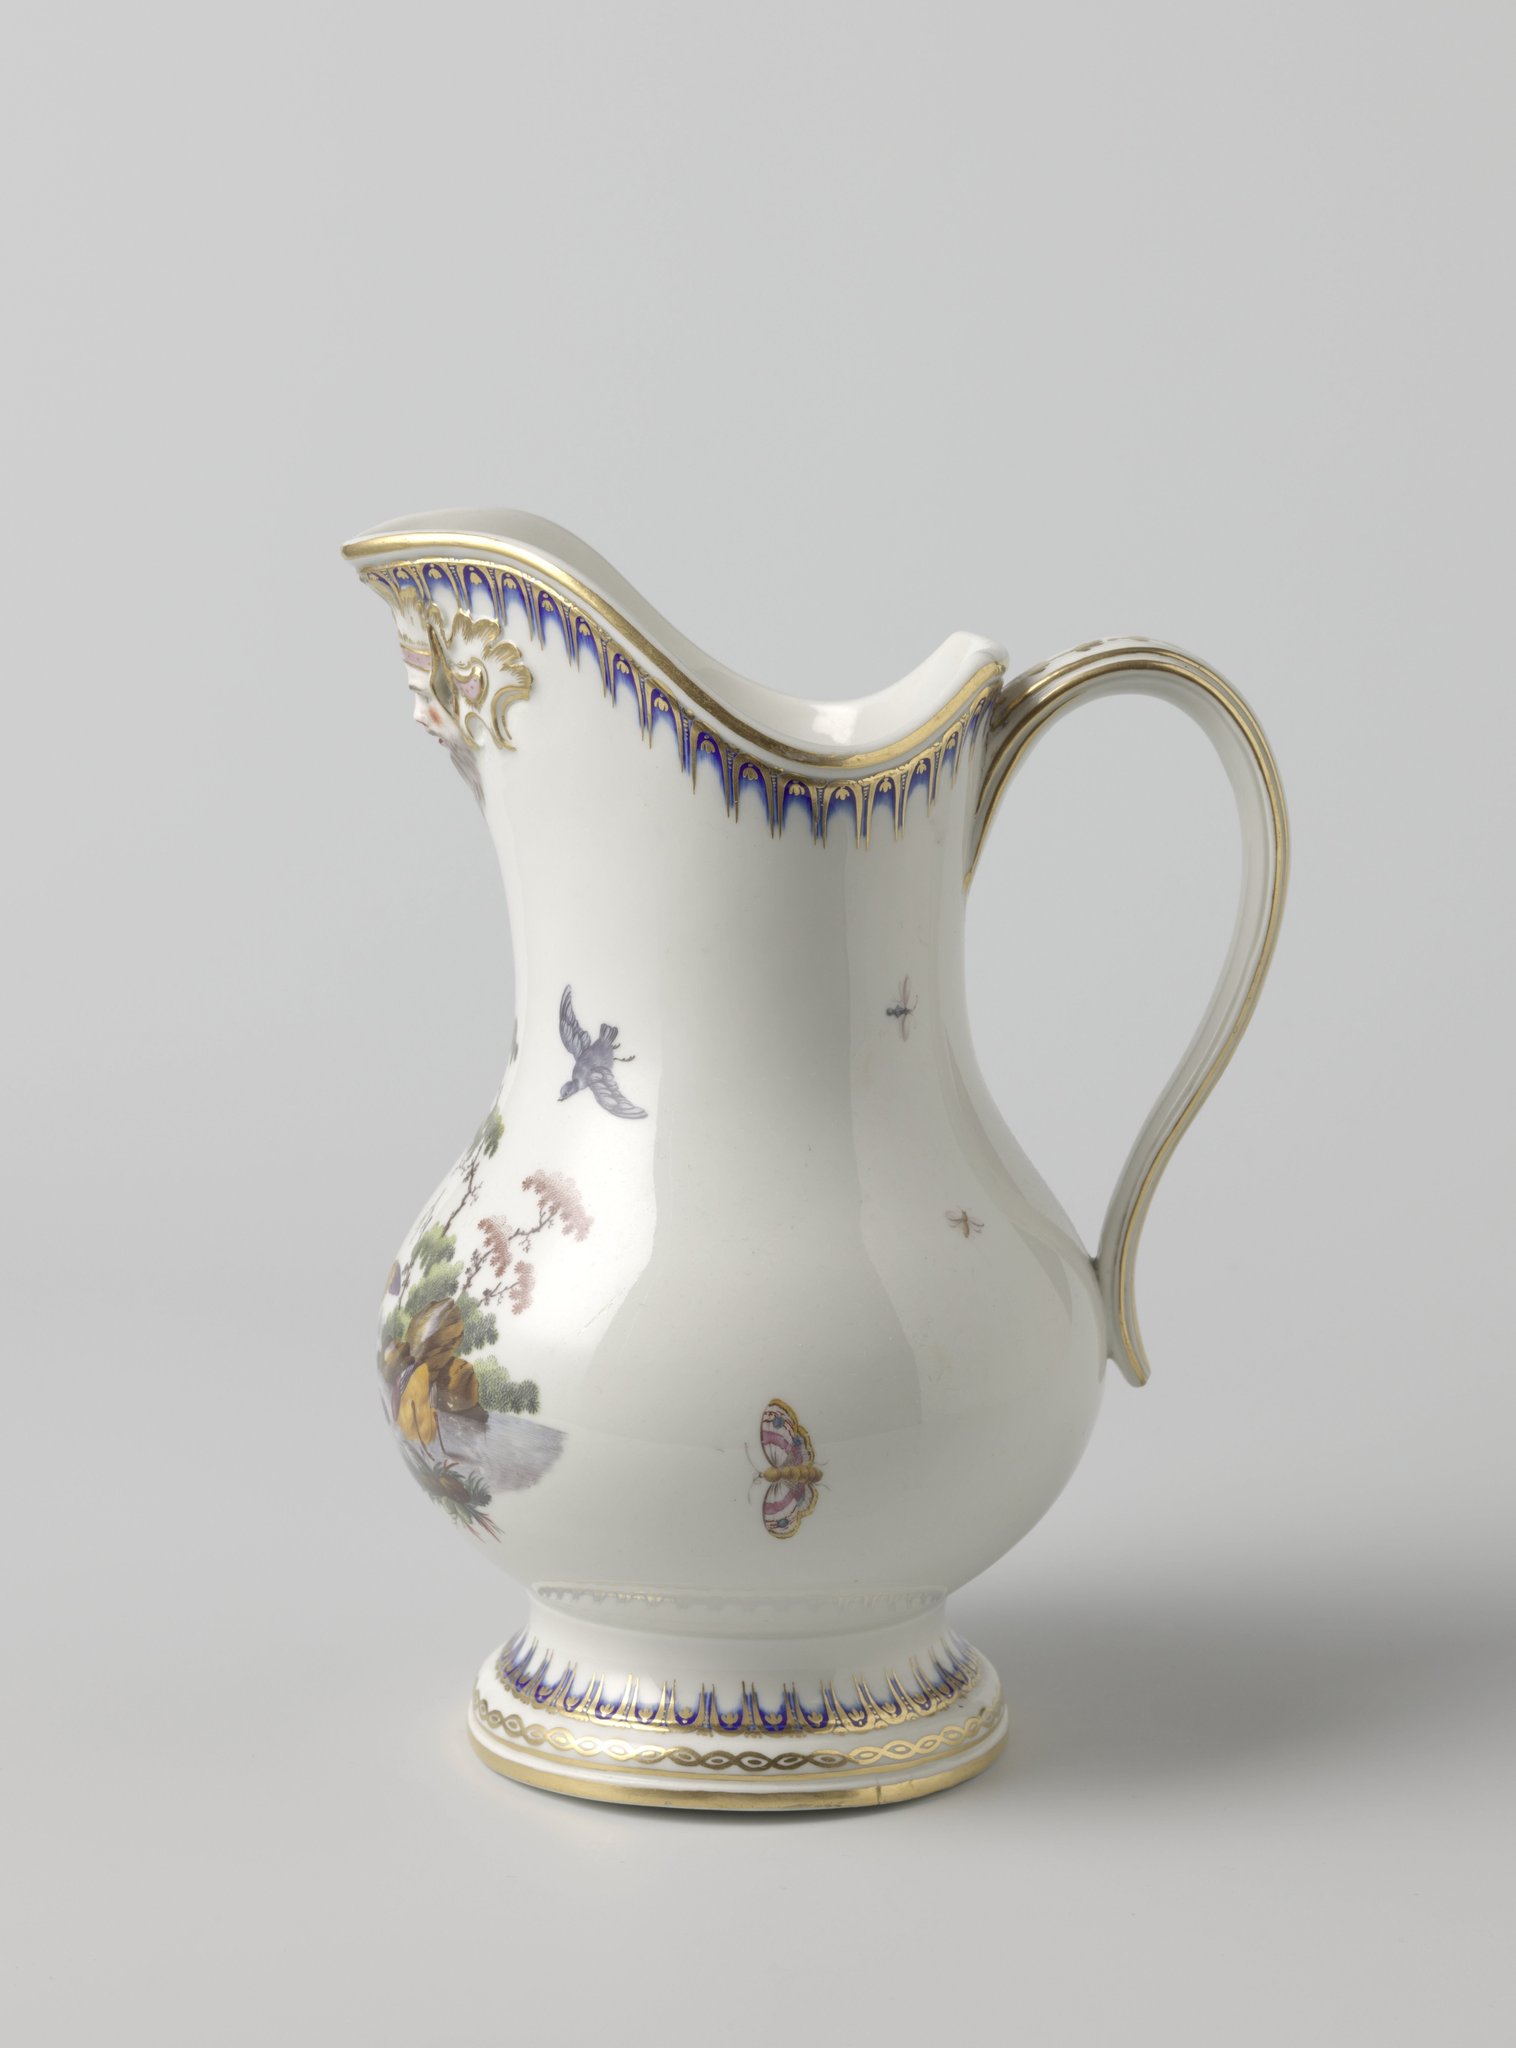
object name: ewer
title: Kan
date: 1777-1790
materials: porcelain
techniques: painted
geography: the hague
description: Ewer. Soft-paste porcelain, the blue decoration under the glaze, the polychrome over it. Tournai, decorated in polychrome in The Hague, c. 1777 - 1790. Factory of Anton Lyncker or his heirs.